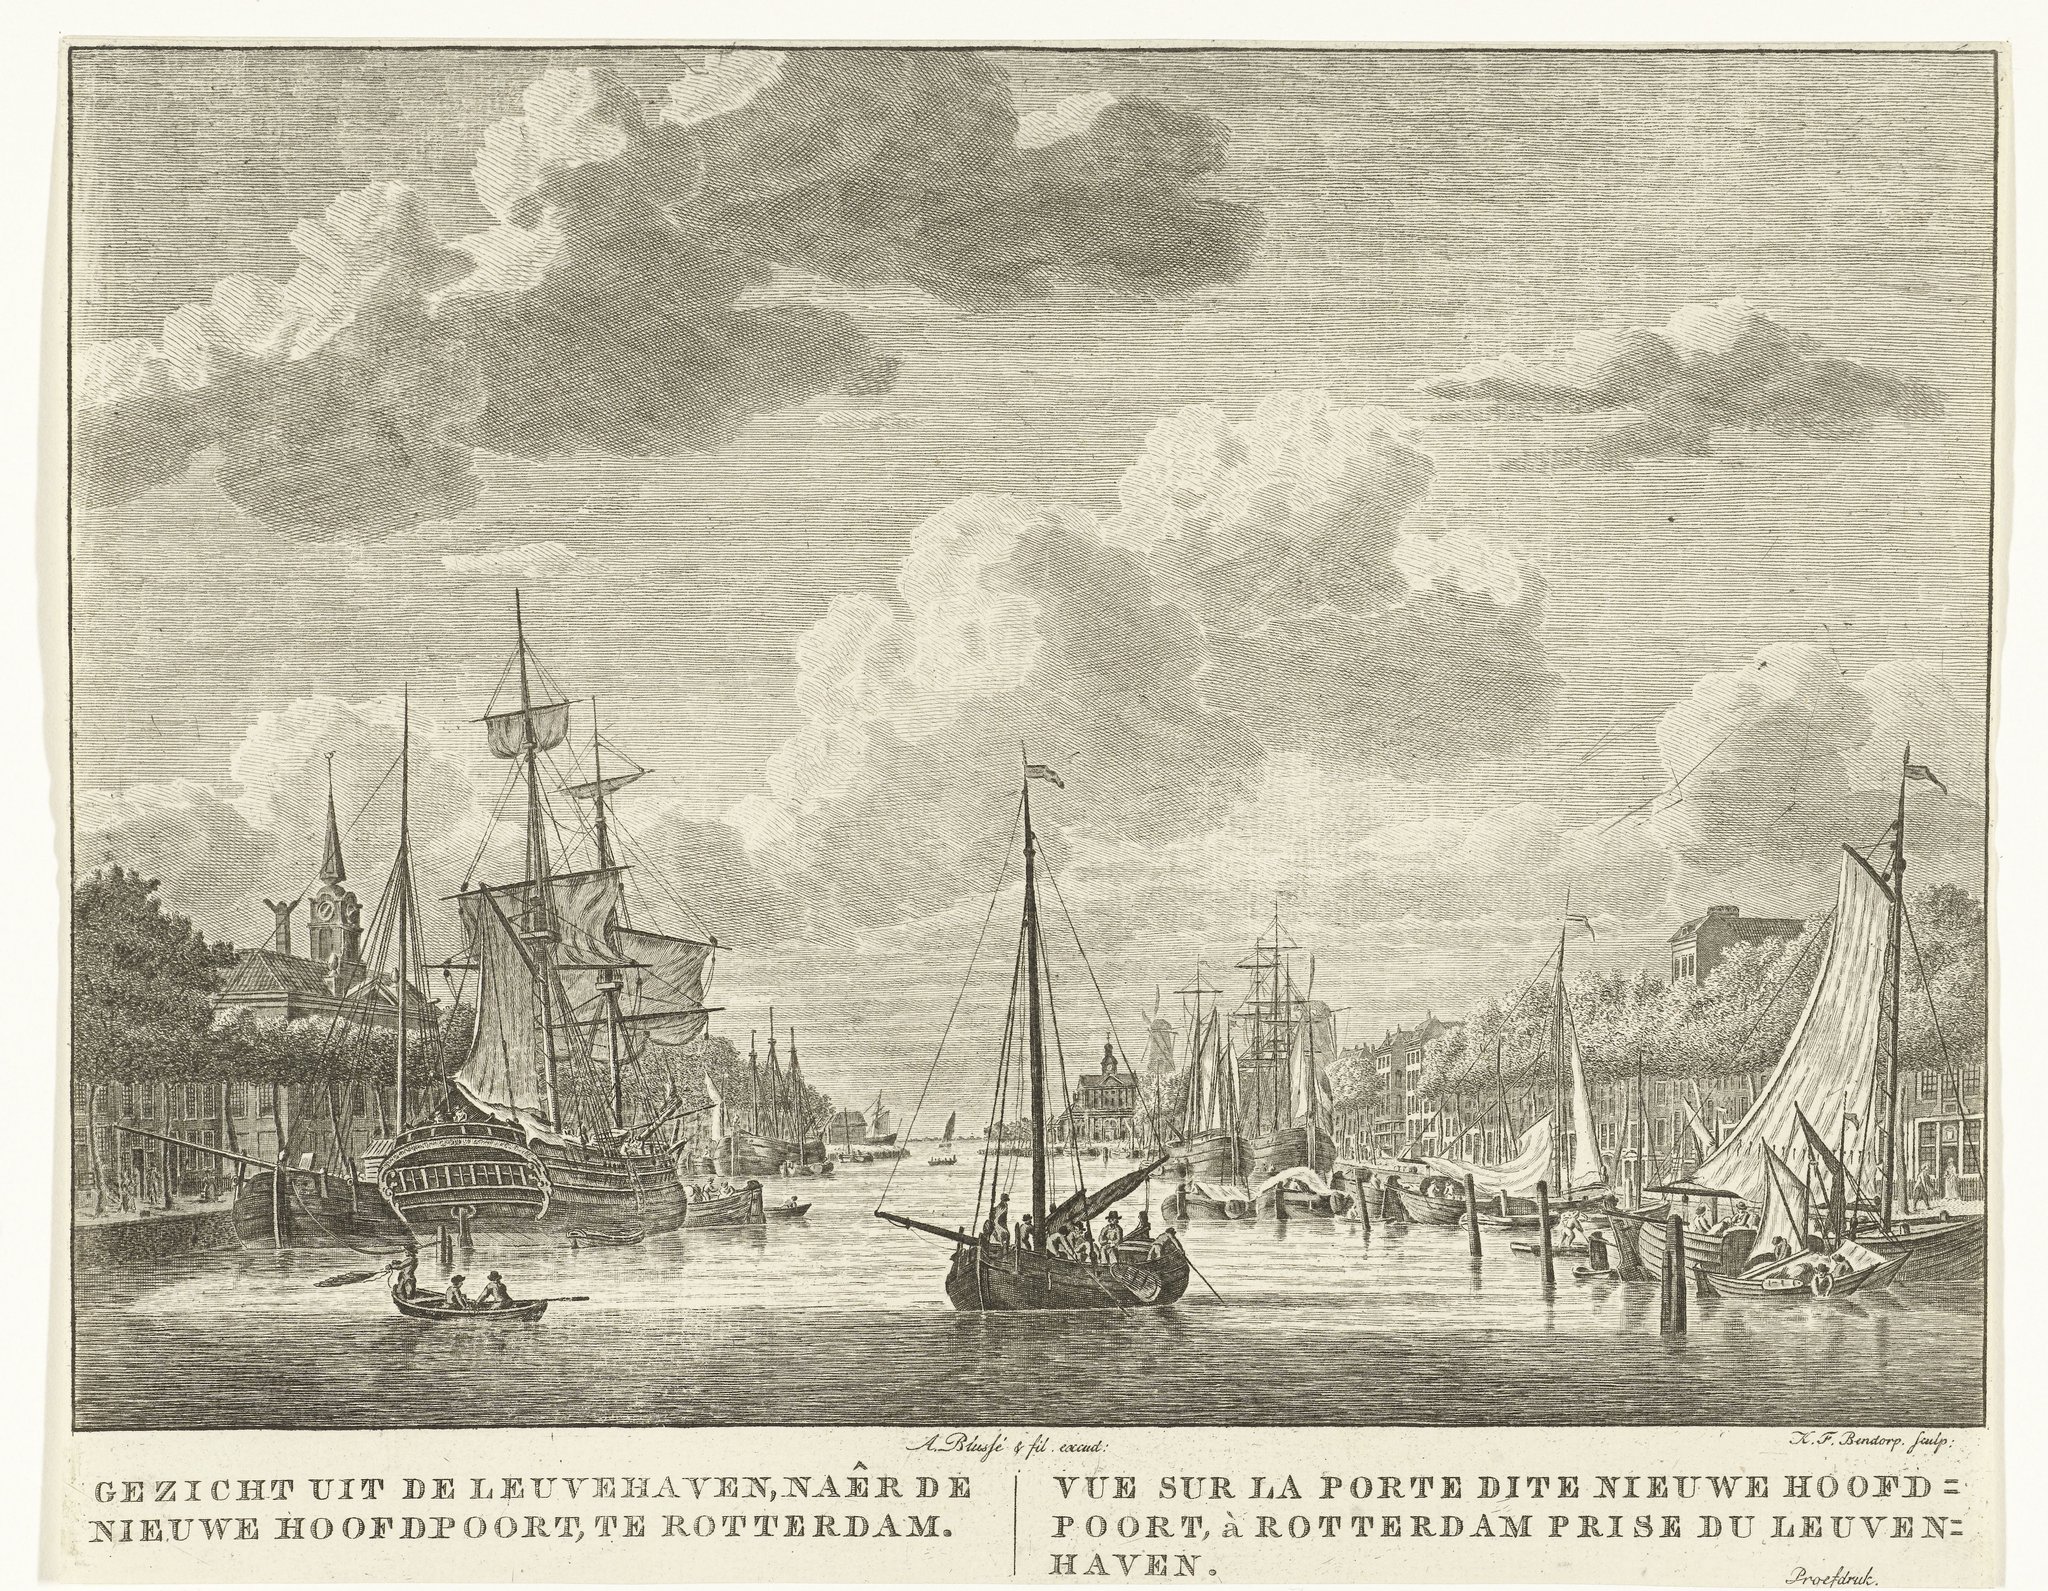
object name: print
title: Gezicht uit de Leuvehaven naer de Nieuwe Hoofdpoort te Rotterdam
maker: carel frederik bendorp (i)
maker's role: print maker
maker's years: 1736-1814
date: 1746-1814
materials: paper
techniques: etching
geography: netherlands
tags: leuvehaven, hoofdpoort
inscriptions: collector's mark: Lugt 2228